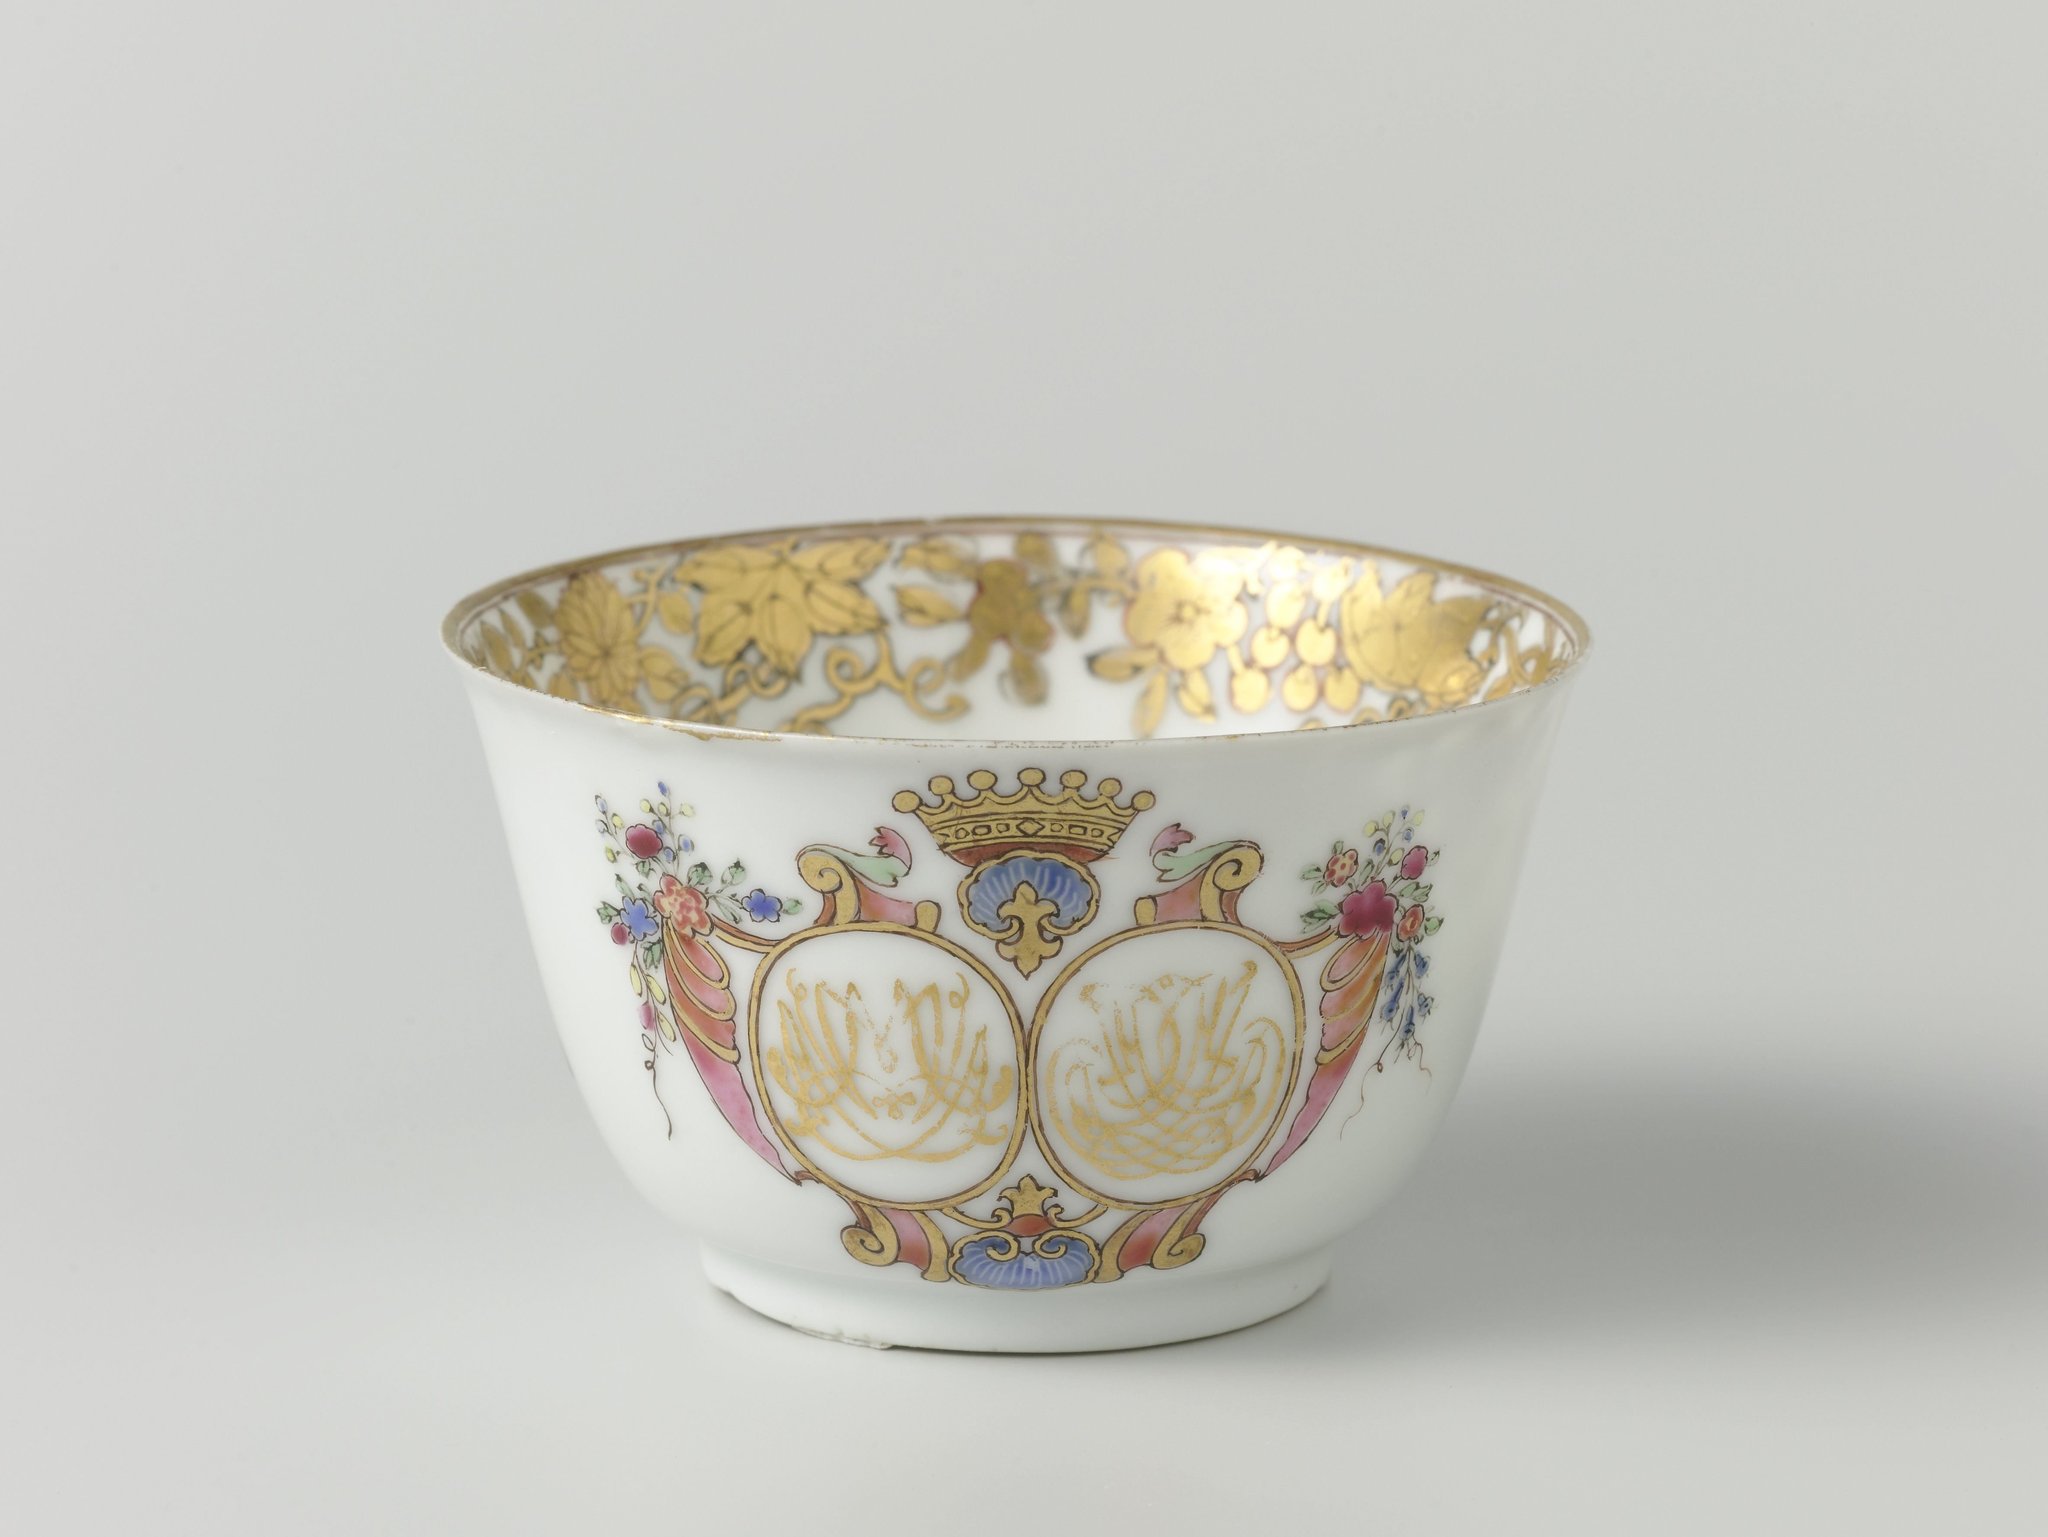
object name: tea cup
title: Bell-shaped cup from the 'Swellengrebel service' with a double crowned monogram and a border with floral scrolls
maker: Anonymous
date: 1740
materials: glaze, gold, paint, porcelain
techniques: firing, gilding, turning, vitrification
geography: china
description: De monogrammen 'MVA' en 'CHTD' staan voor Maurits van Aerden (1694-1746) en Constantia Helena ten Damme (1694-1772), getrouwd in 1716. Het servies is waarschijnlijk besteld ter ere van hun vijfentwingtigjarig huwelijksjubileum in 1741. (Campen, Jan van & Hartkamp-Jonxis, Ebeltje, Aziatische weelde : VOC-kunst in het Rijksmuseum, Zutphen 2011, p. 78)